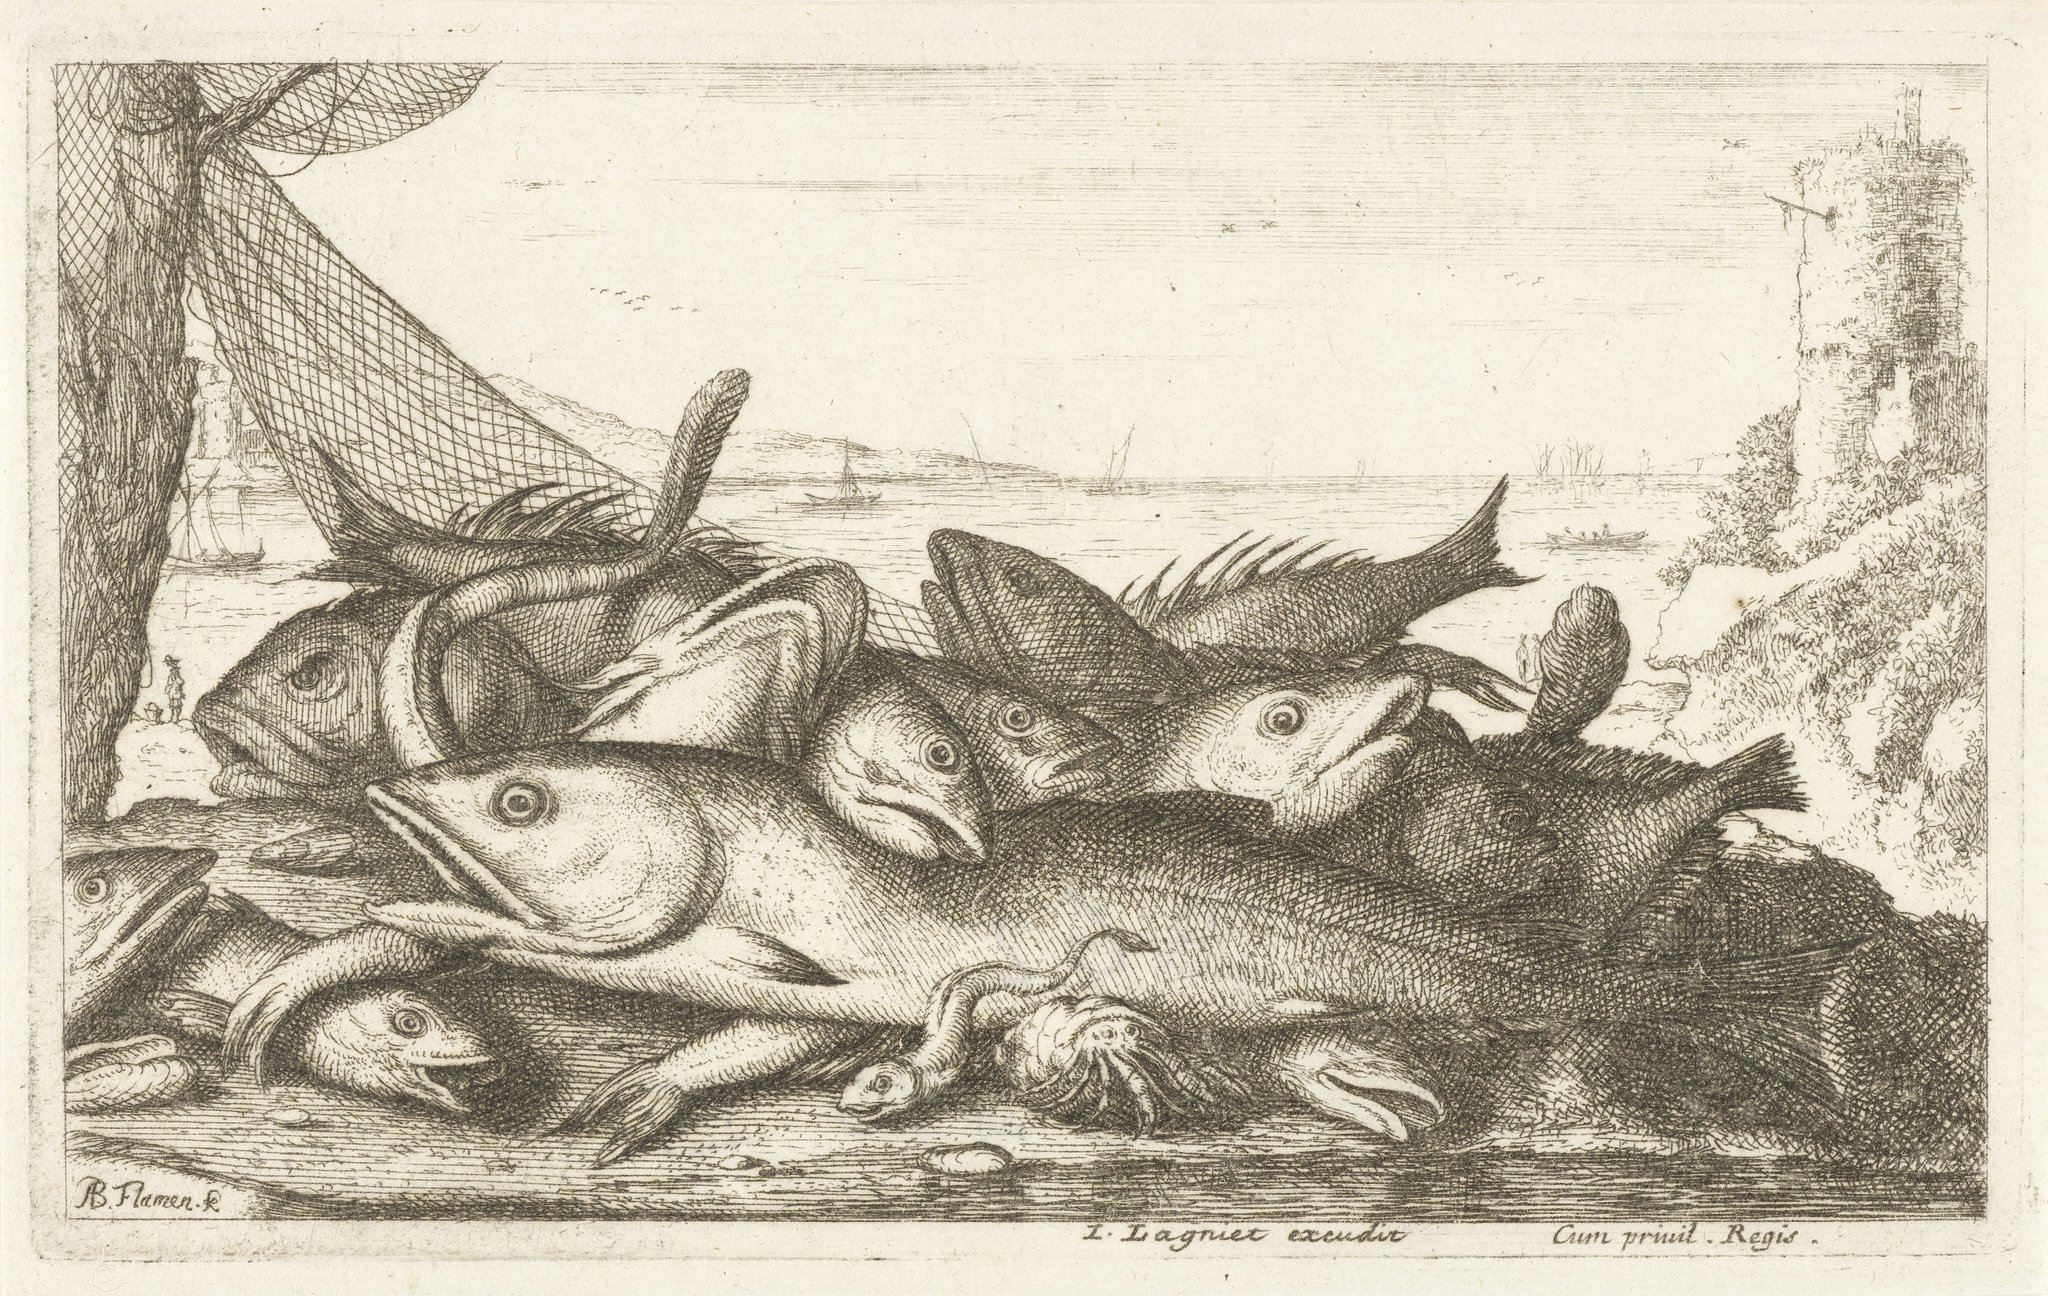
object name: print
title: Diverses Especes De Poissons tant de Mer, que d'Eeau douce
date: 1648-1670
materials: paper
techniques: etching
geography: paris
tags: fishes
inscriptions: collector's mark: Lugt 2228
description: Verschillende vissen op een hoop, bij een visnet. Op de achtergrond een toren op de oever van een brede rivier.